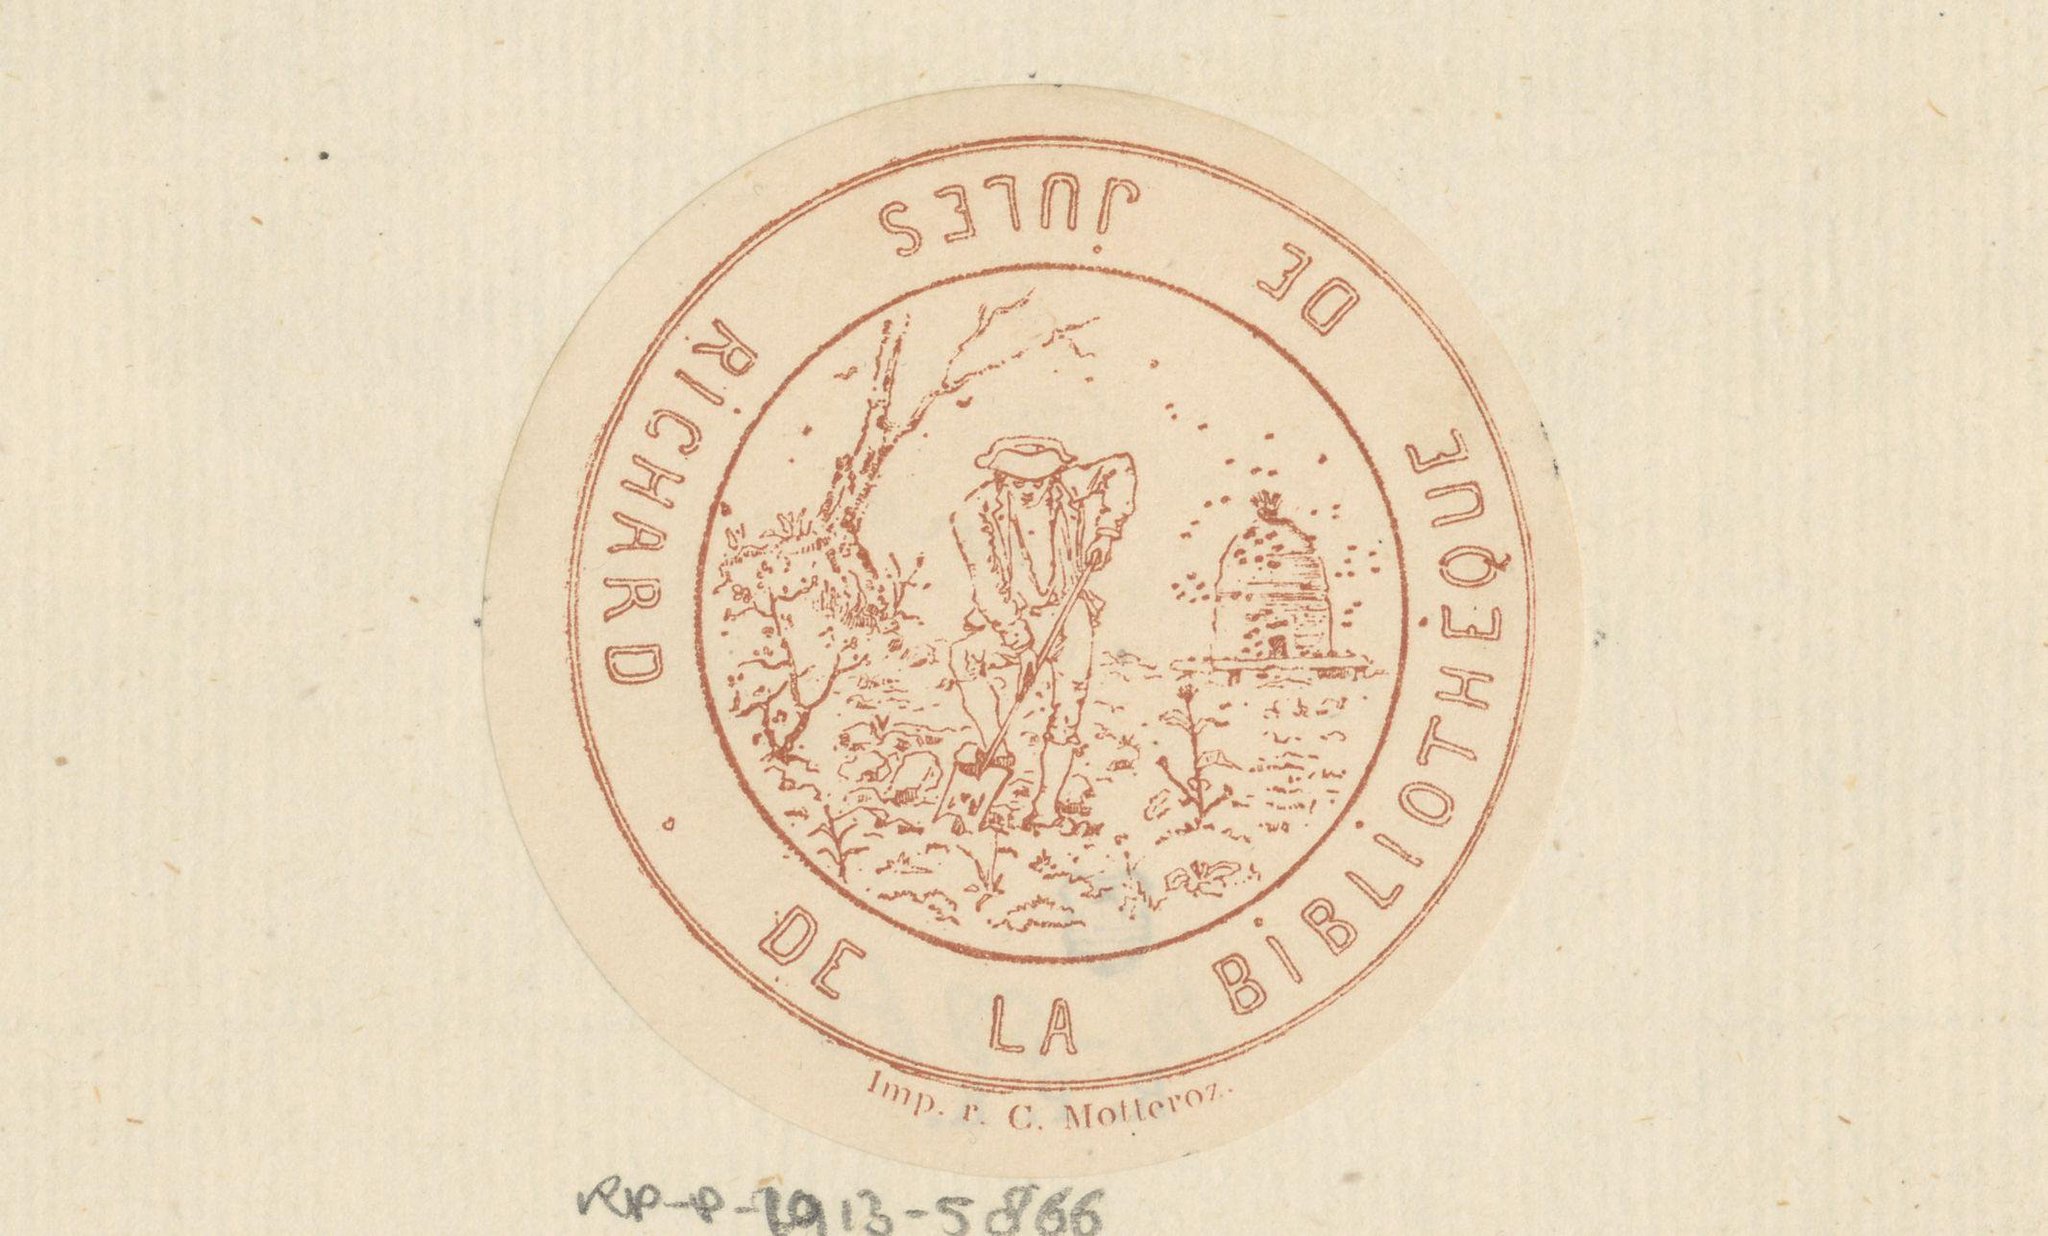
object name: bookplate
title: De la bibliothèque de Jules Richard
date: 1870-1913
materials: paper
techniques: lithograph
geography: france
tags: standing figure, soil cultivation, bee-hive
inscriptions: collector's mark: Lugt 2760, collector's mark: Lugt 2233